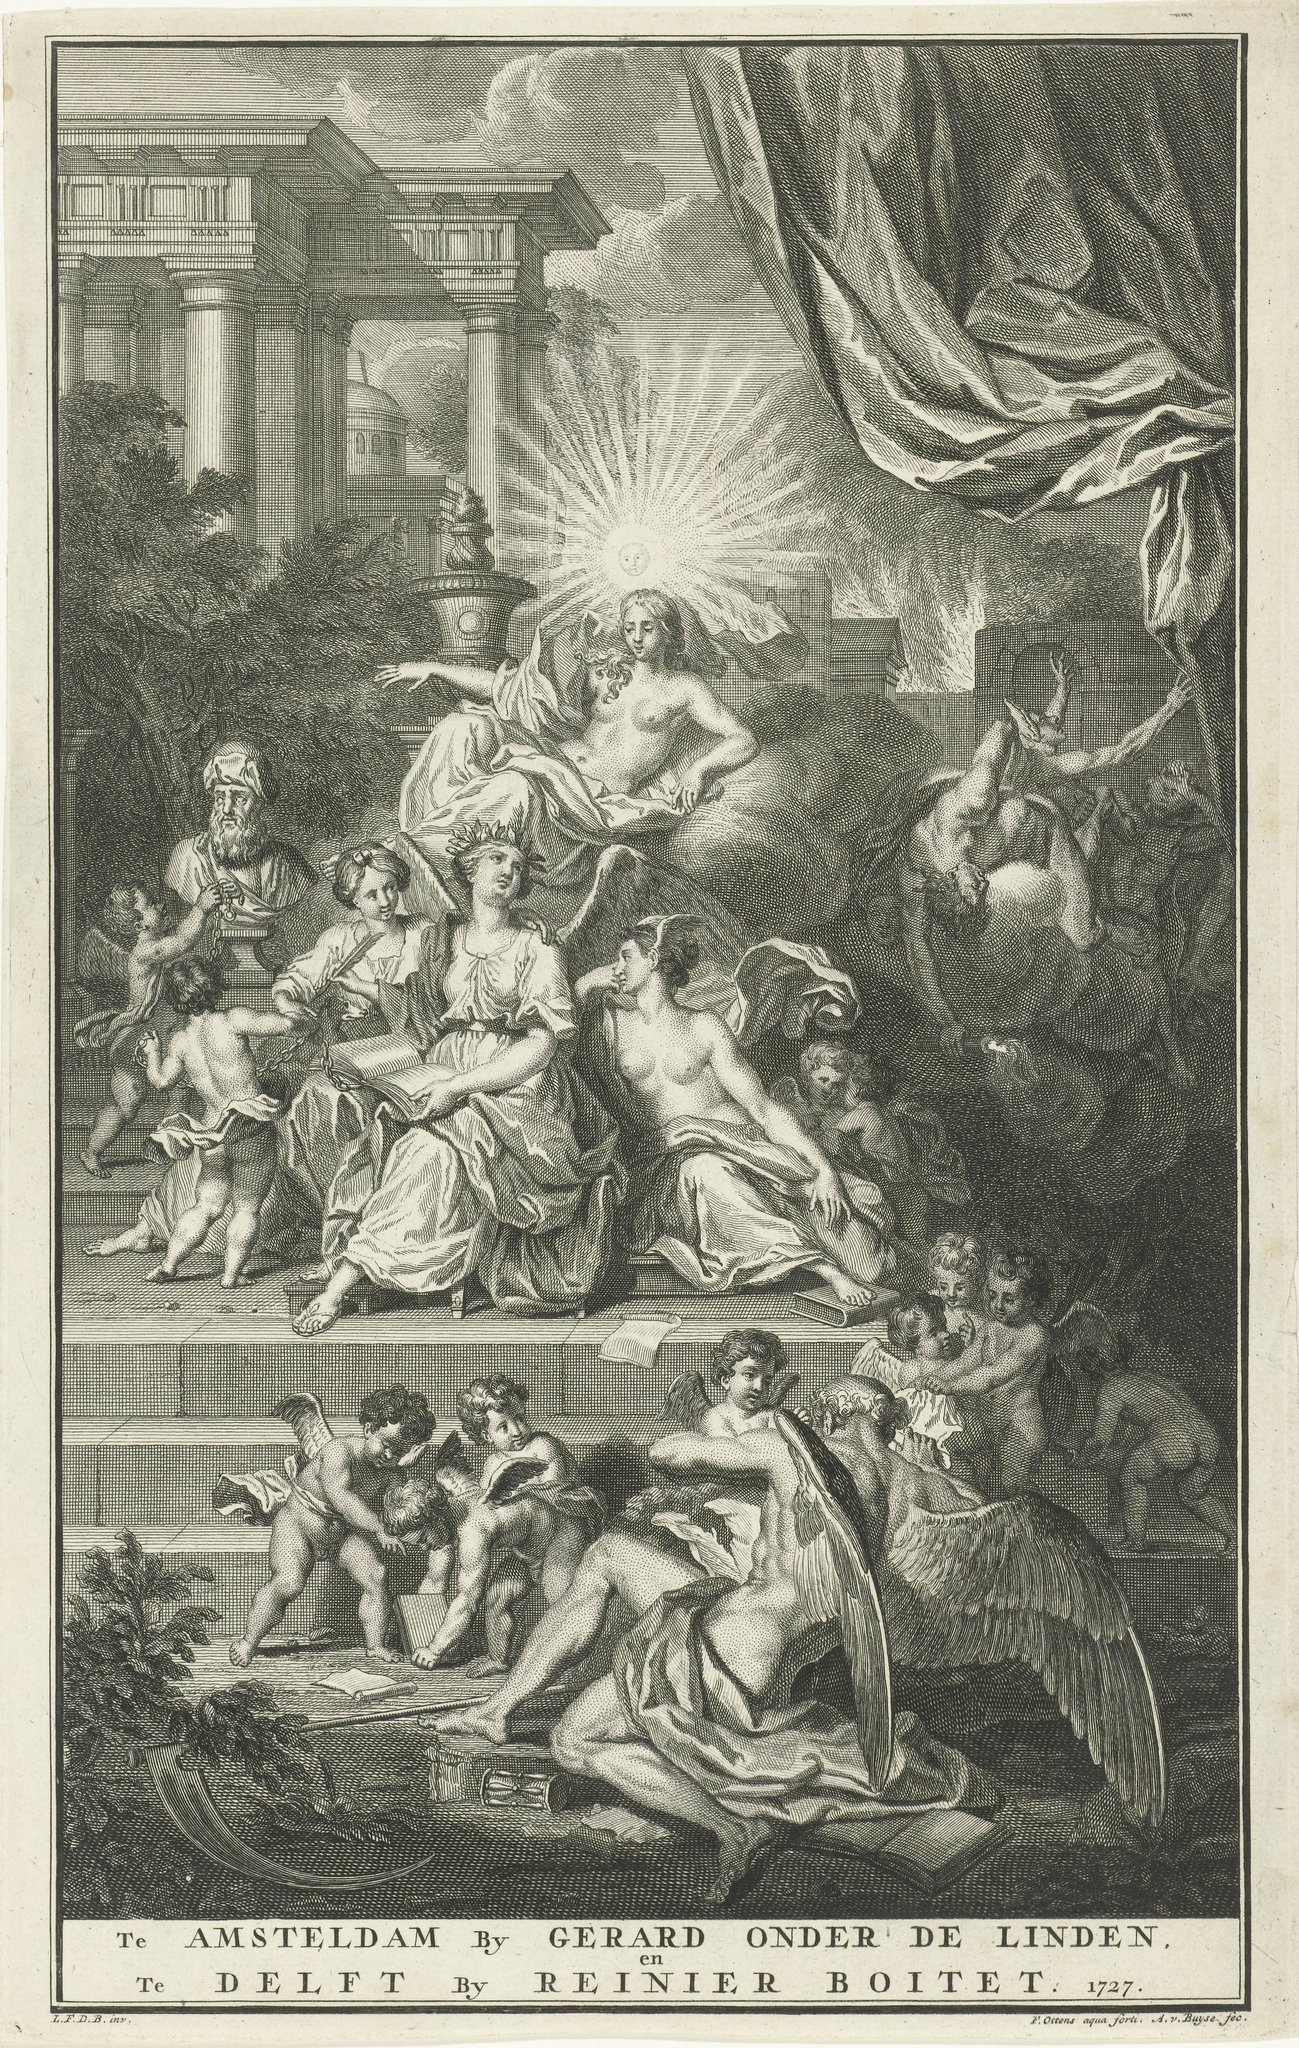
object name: titelblad, titelpagina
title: Titelpagina voor: Vervolg op Flavius Josephus: of Algemene historie der joodsche naatsie. 1727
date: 1727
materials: paper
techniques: engraving, etching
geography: delft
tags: 'historia'; 'historia' (ripa), father time, man with wings and scythe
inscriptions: collector's mark: Lugt 2228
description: De personificatie van de geschiedschrijving, een gevleugelde vrouw schrijvend in een boek, zit op een trap omringd door putti en andere figuren. Beneden aan de trap speelt Vader Tijd met een groepje putti. Op de achtergrond valt een jonge man met een brandende toorts van een muur. De gebouwen achter de muur staan in brand.